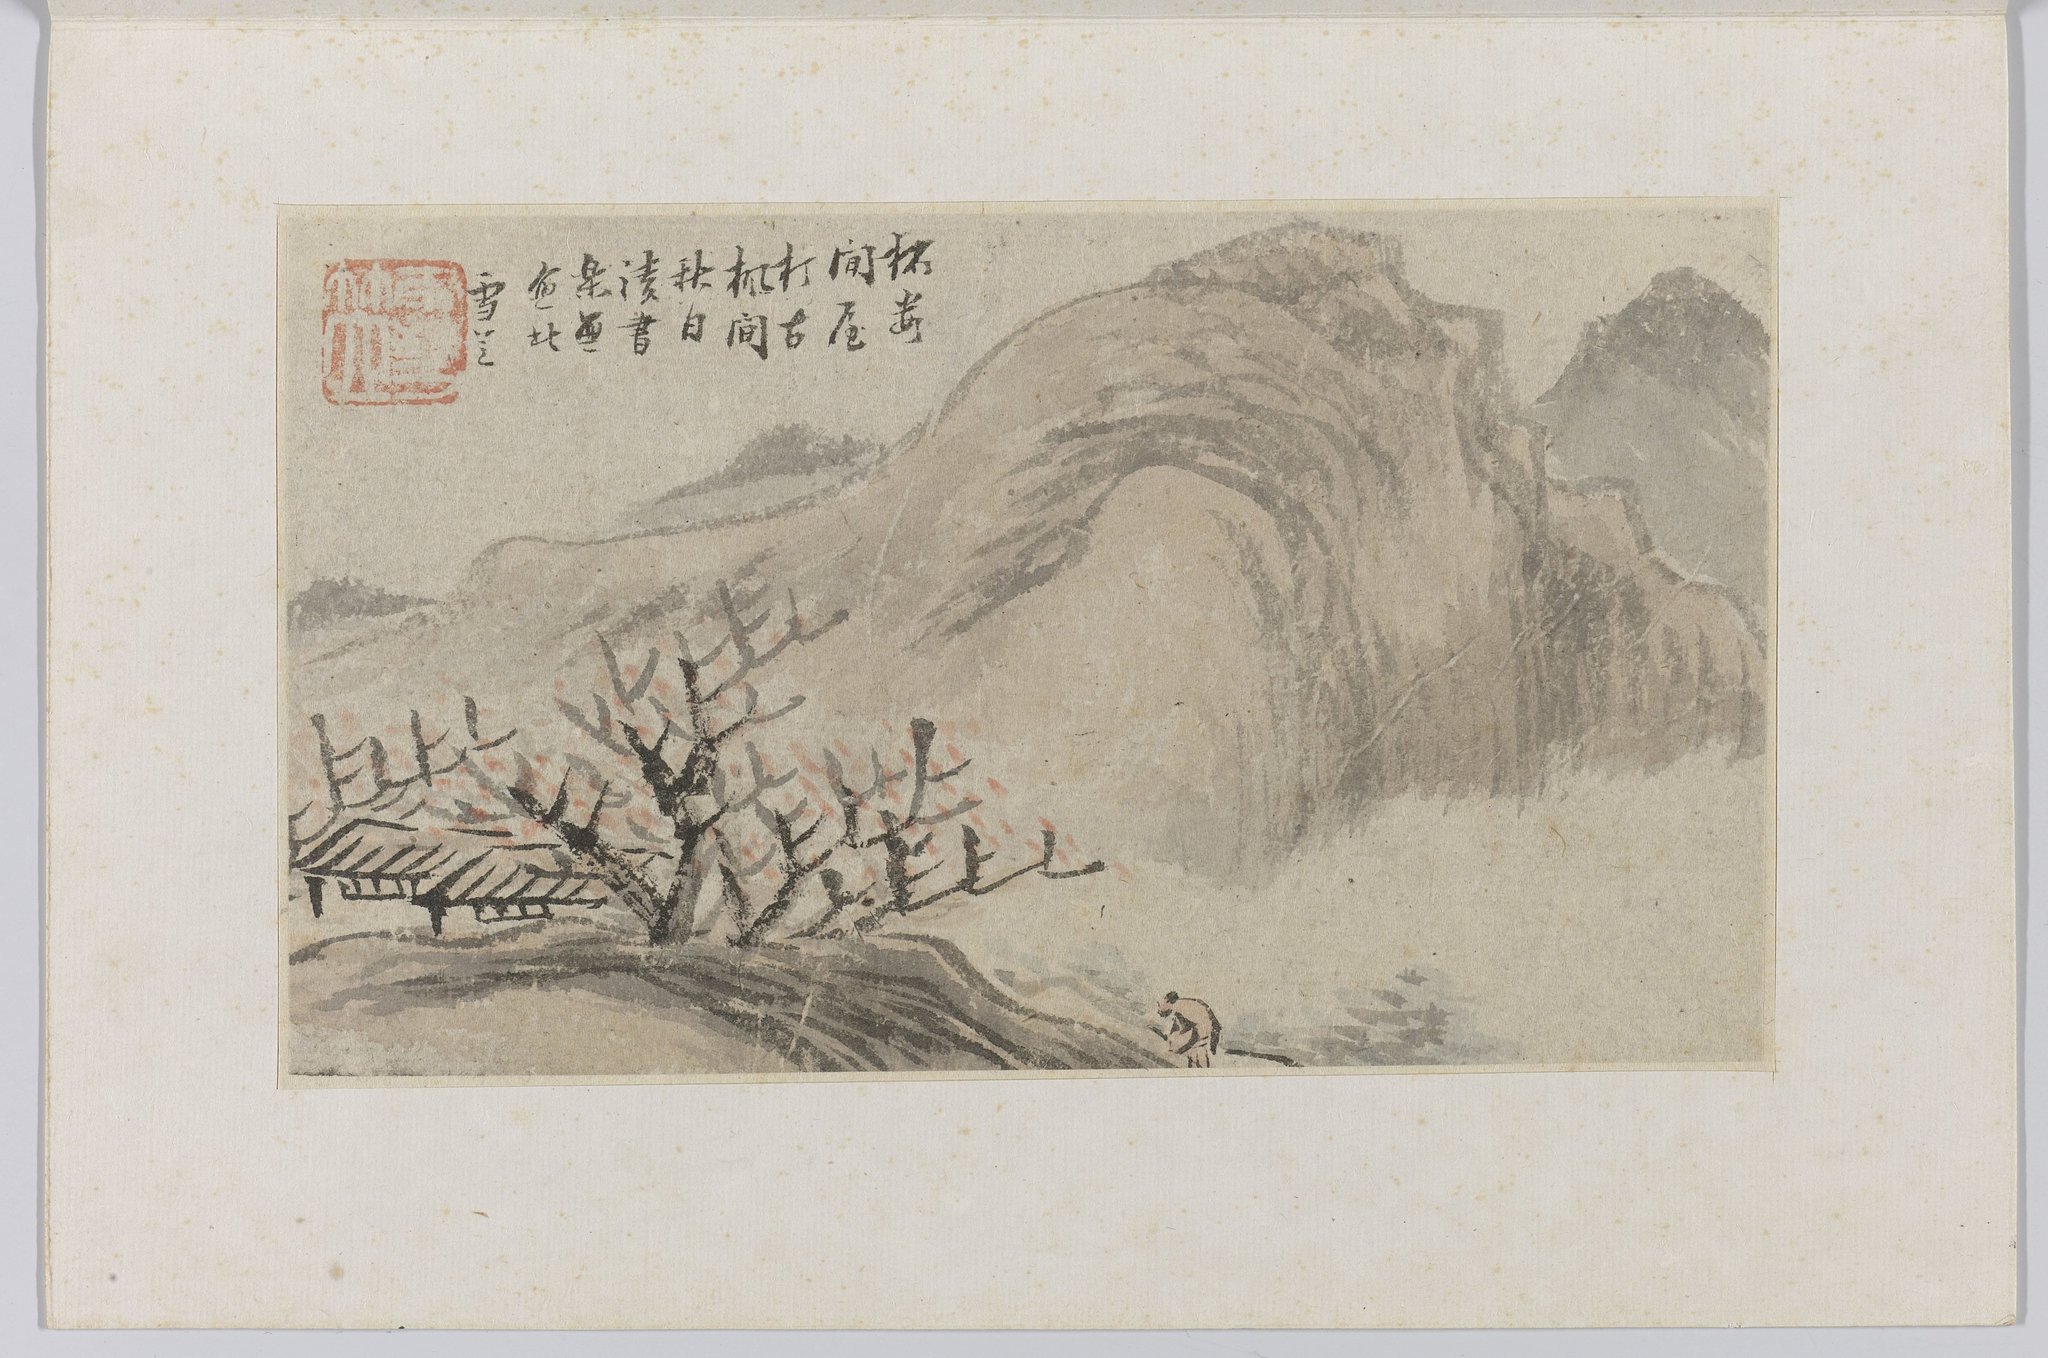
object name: album leaf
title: Landschap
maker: cheng men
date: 1850-1900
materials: ink, paper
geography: shexian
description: Albumblad met een landschap. Gesigneerd door Cheng Men, bekend als porseleinschilder in Jingdezhen.